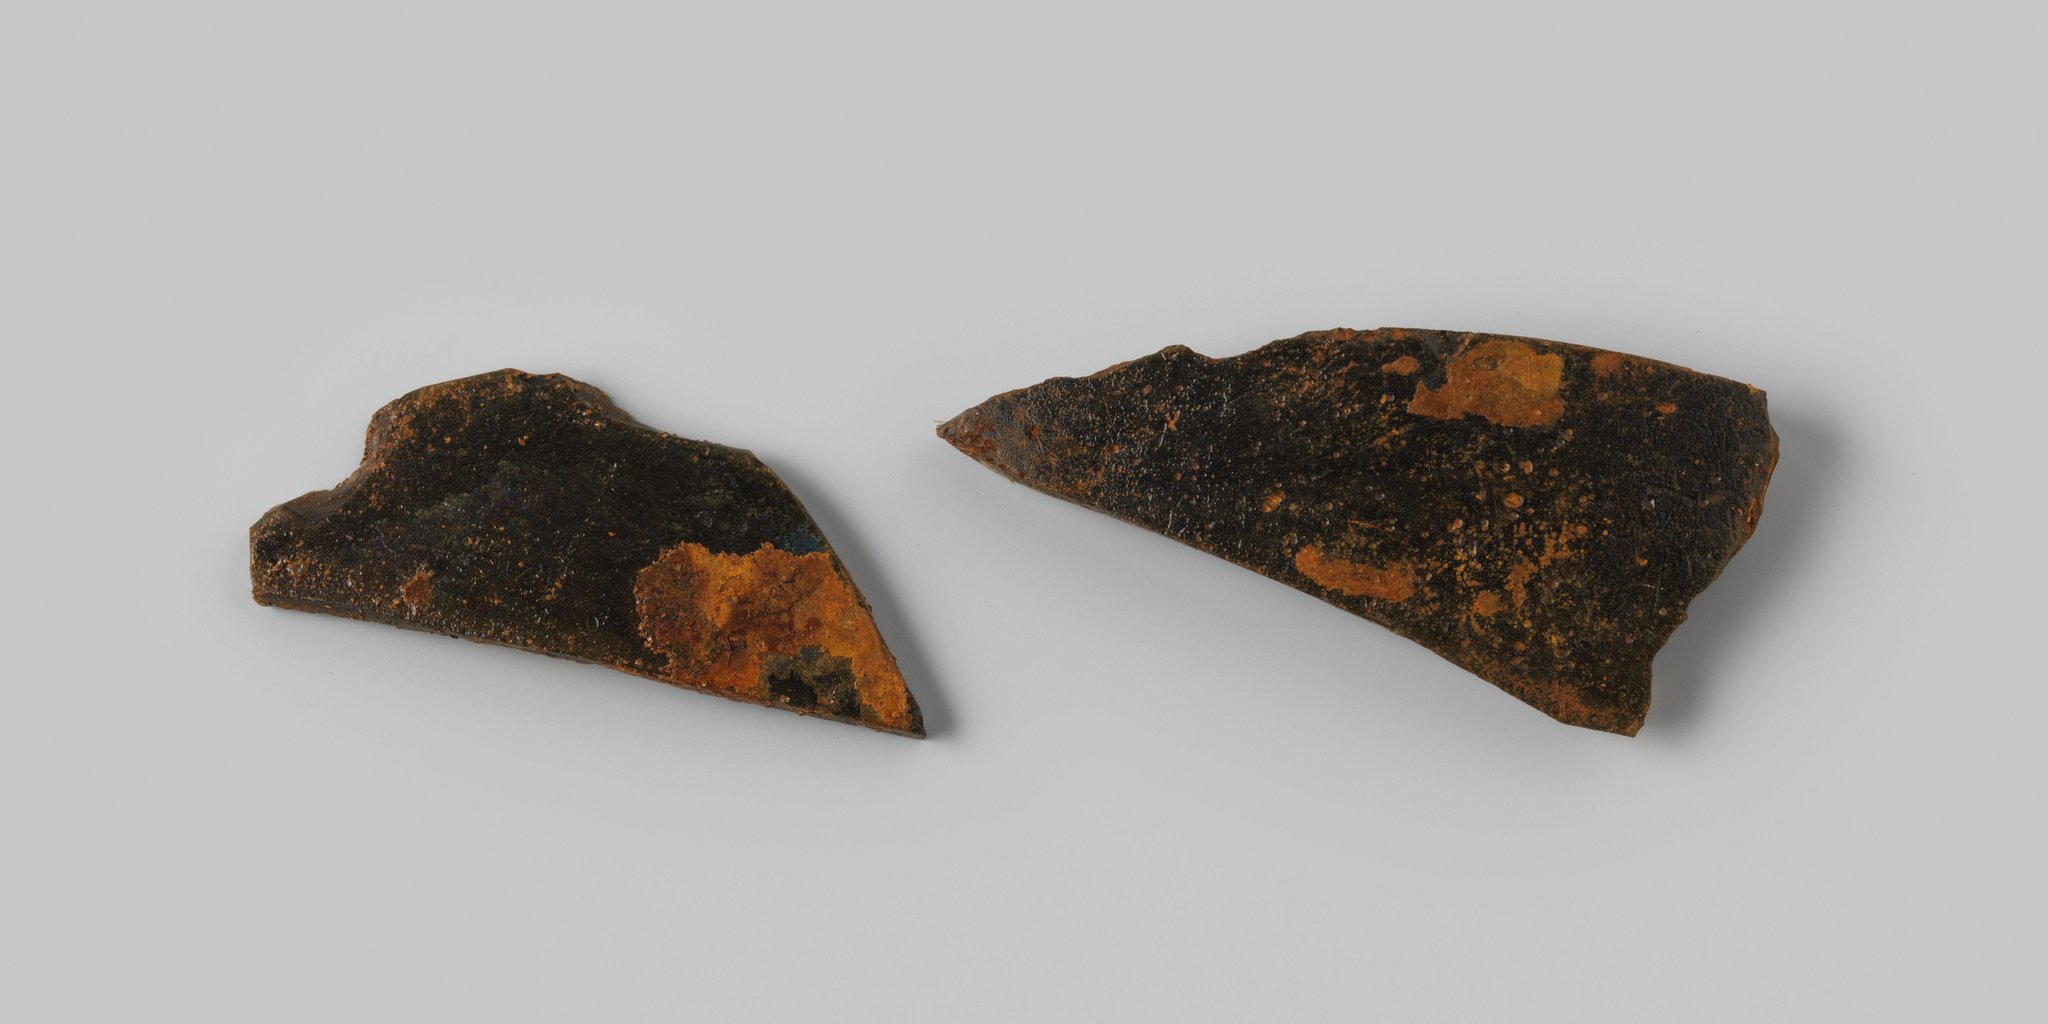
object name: sherd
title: Scherven van wijnflessen uit het wrak van de Oost-Indiëvaarder Hollandia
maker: Anonymous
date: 1700-1743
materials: glass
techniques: green glass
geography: netherlands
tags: verenigde oostindische compagnie, hollandia (schip), annet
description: Typologically not identifiable, belly, fragment.